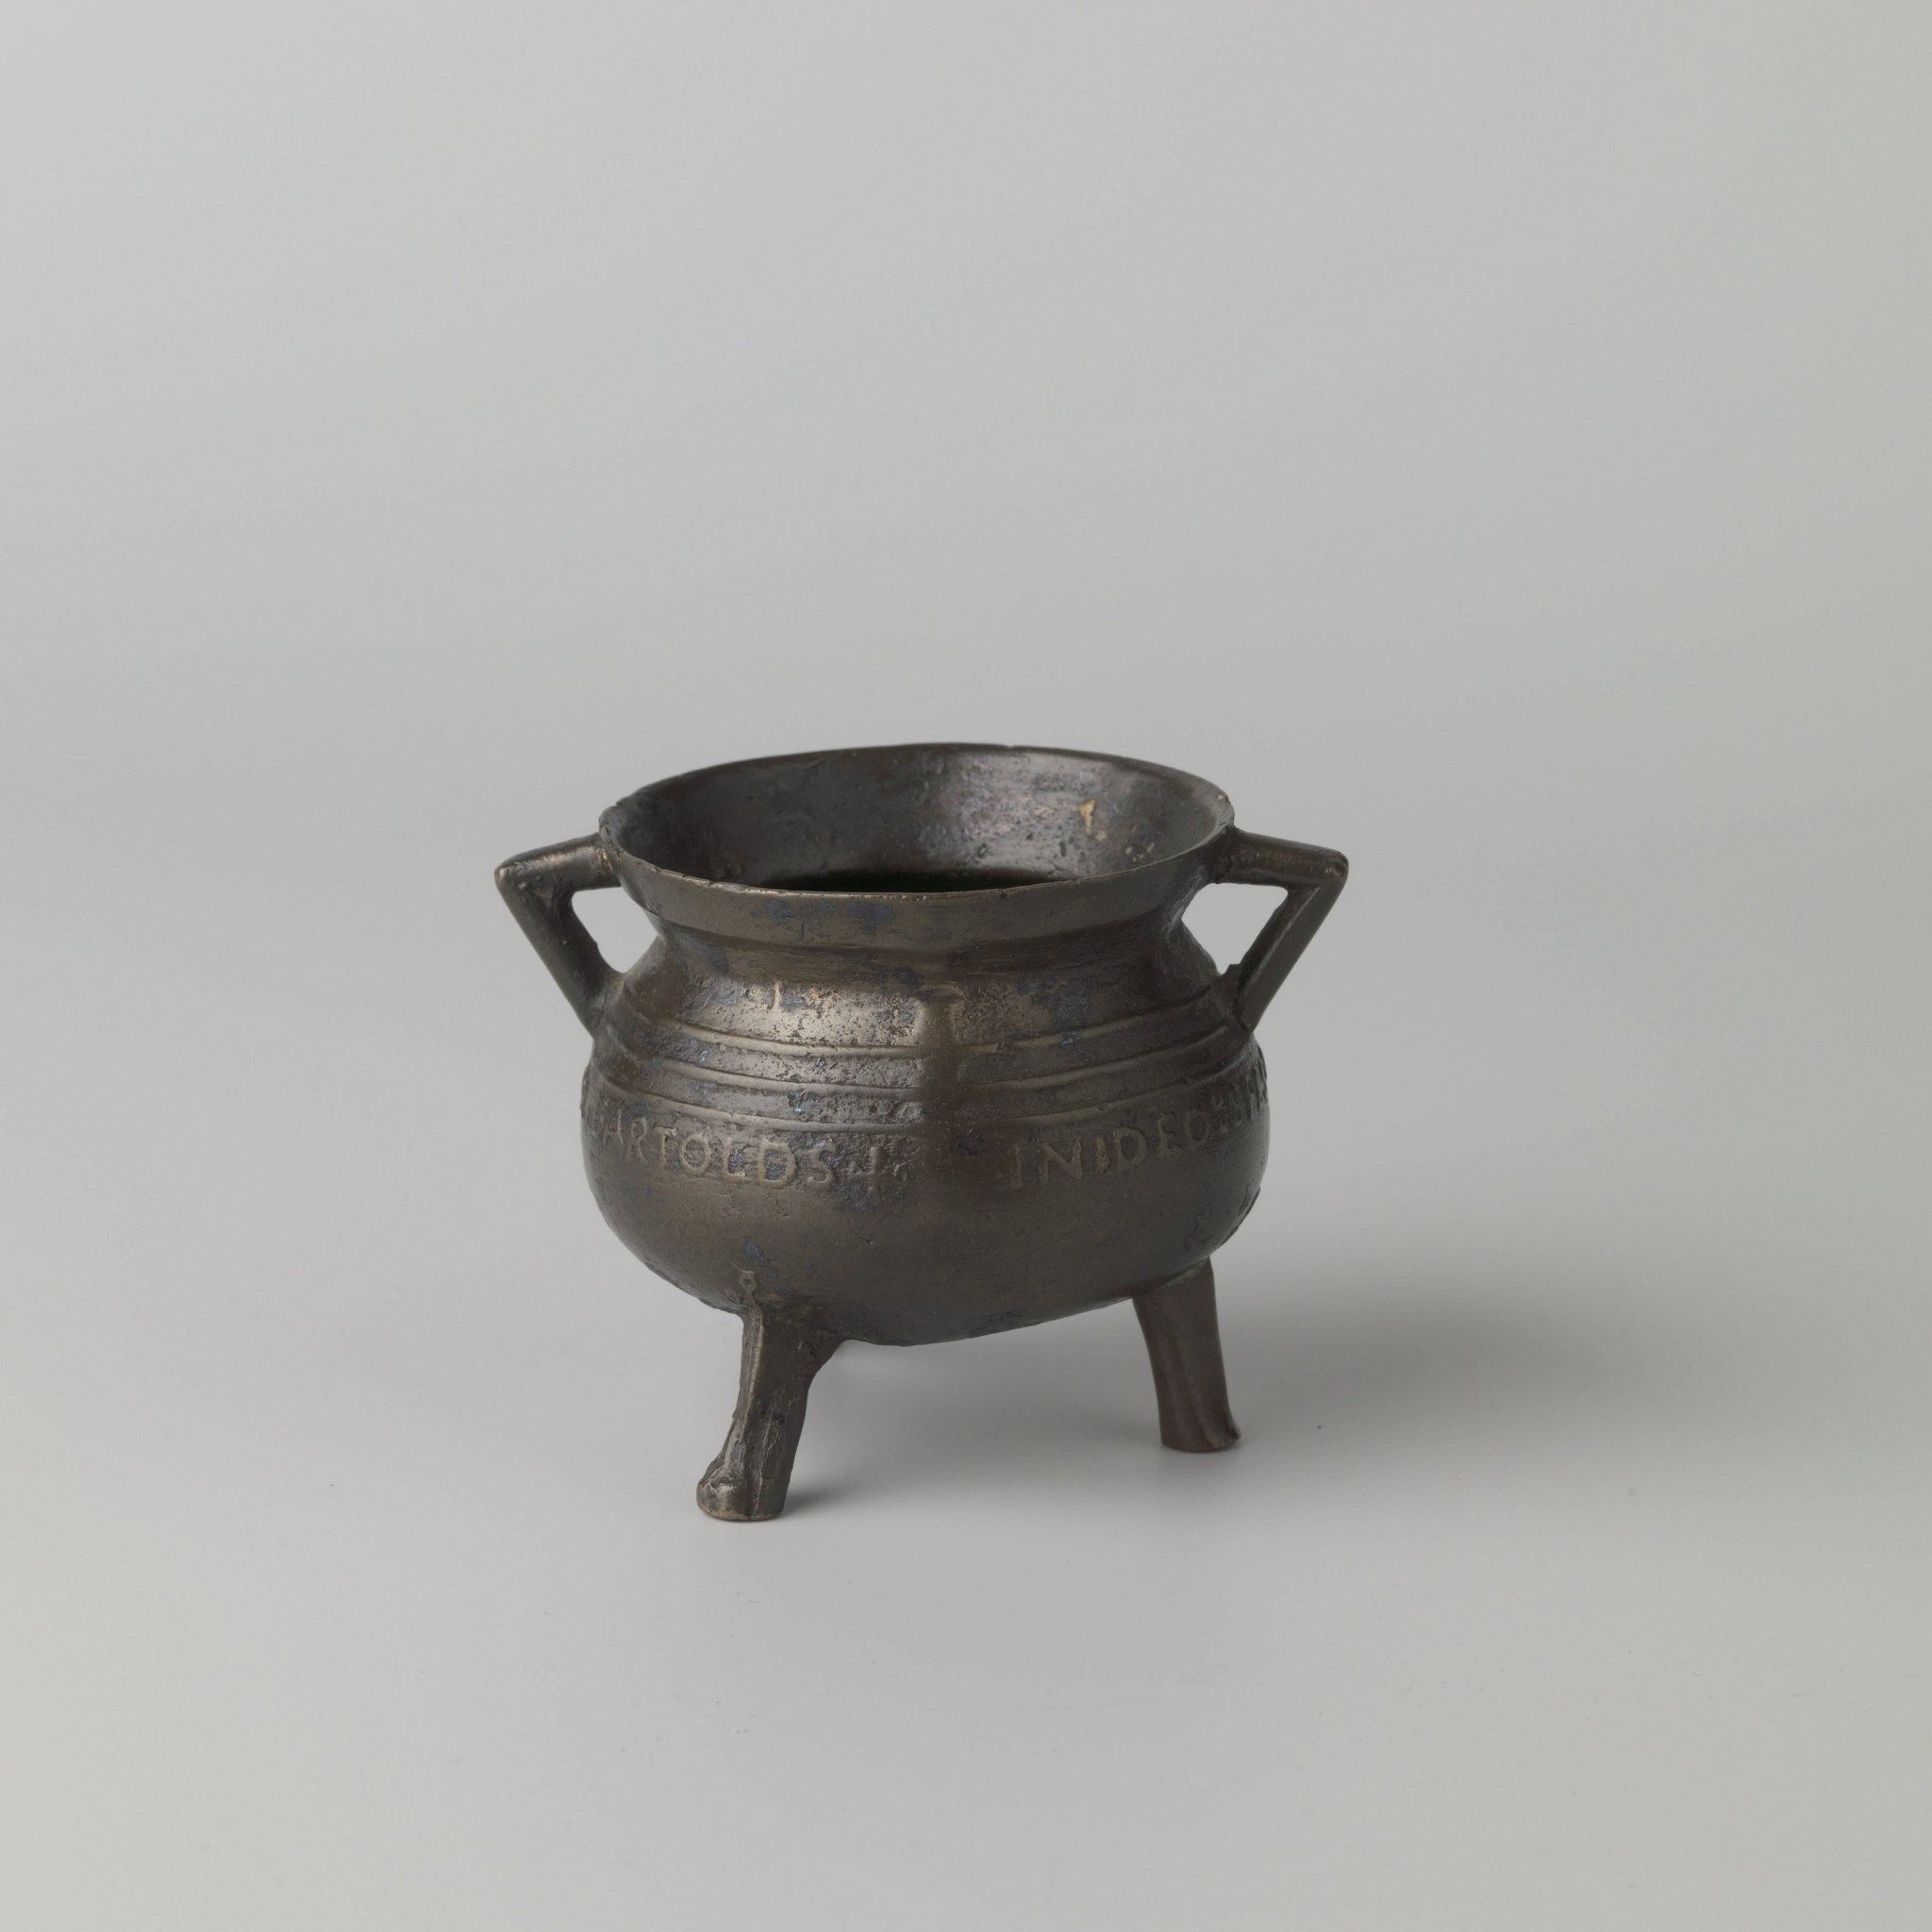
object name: cauldron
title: Kookpot met opschrift: MARGRIETIEN BARTOLDS IN DEO SPES MEA ANO 1635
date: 1635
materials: bronze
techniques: brazing, casting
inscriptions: inscription: ‘MARGRIETIEN BARTOLDS IN DEO SPES MEA ANO 1635’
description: Cooking pot. Bronze. Netherlands, 1635.